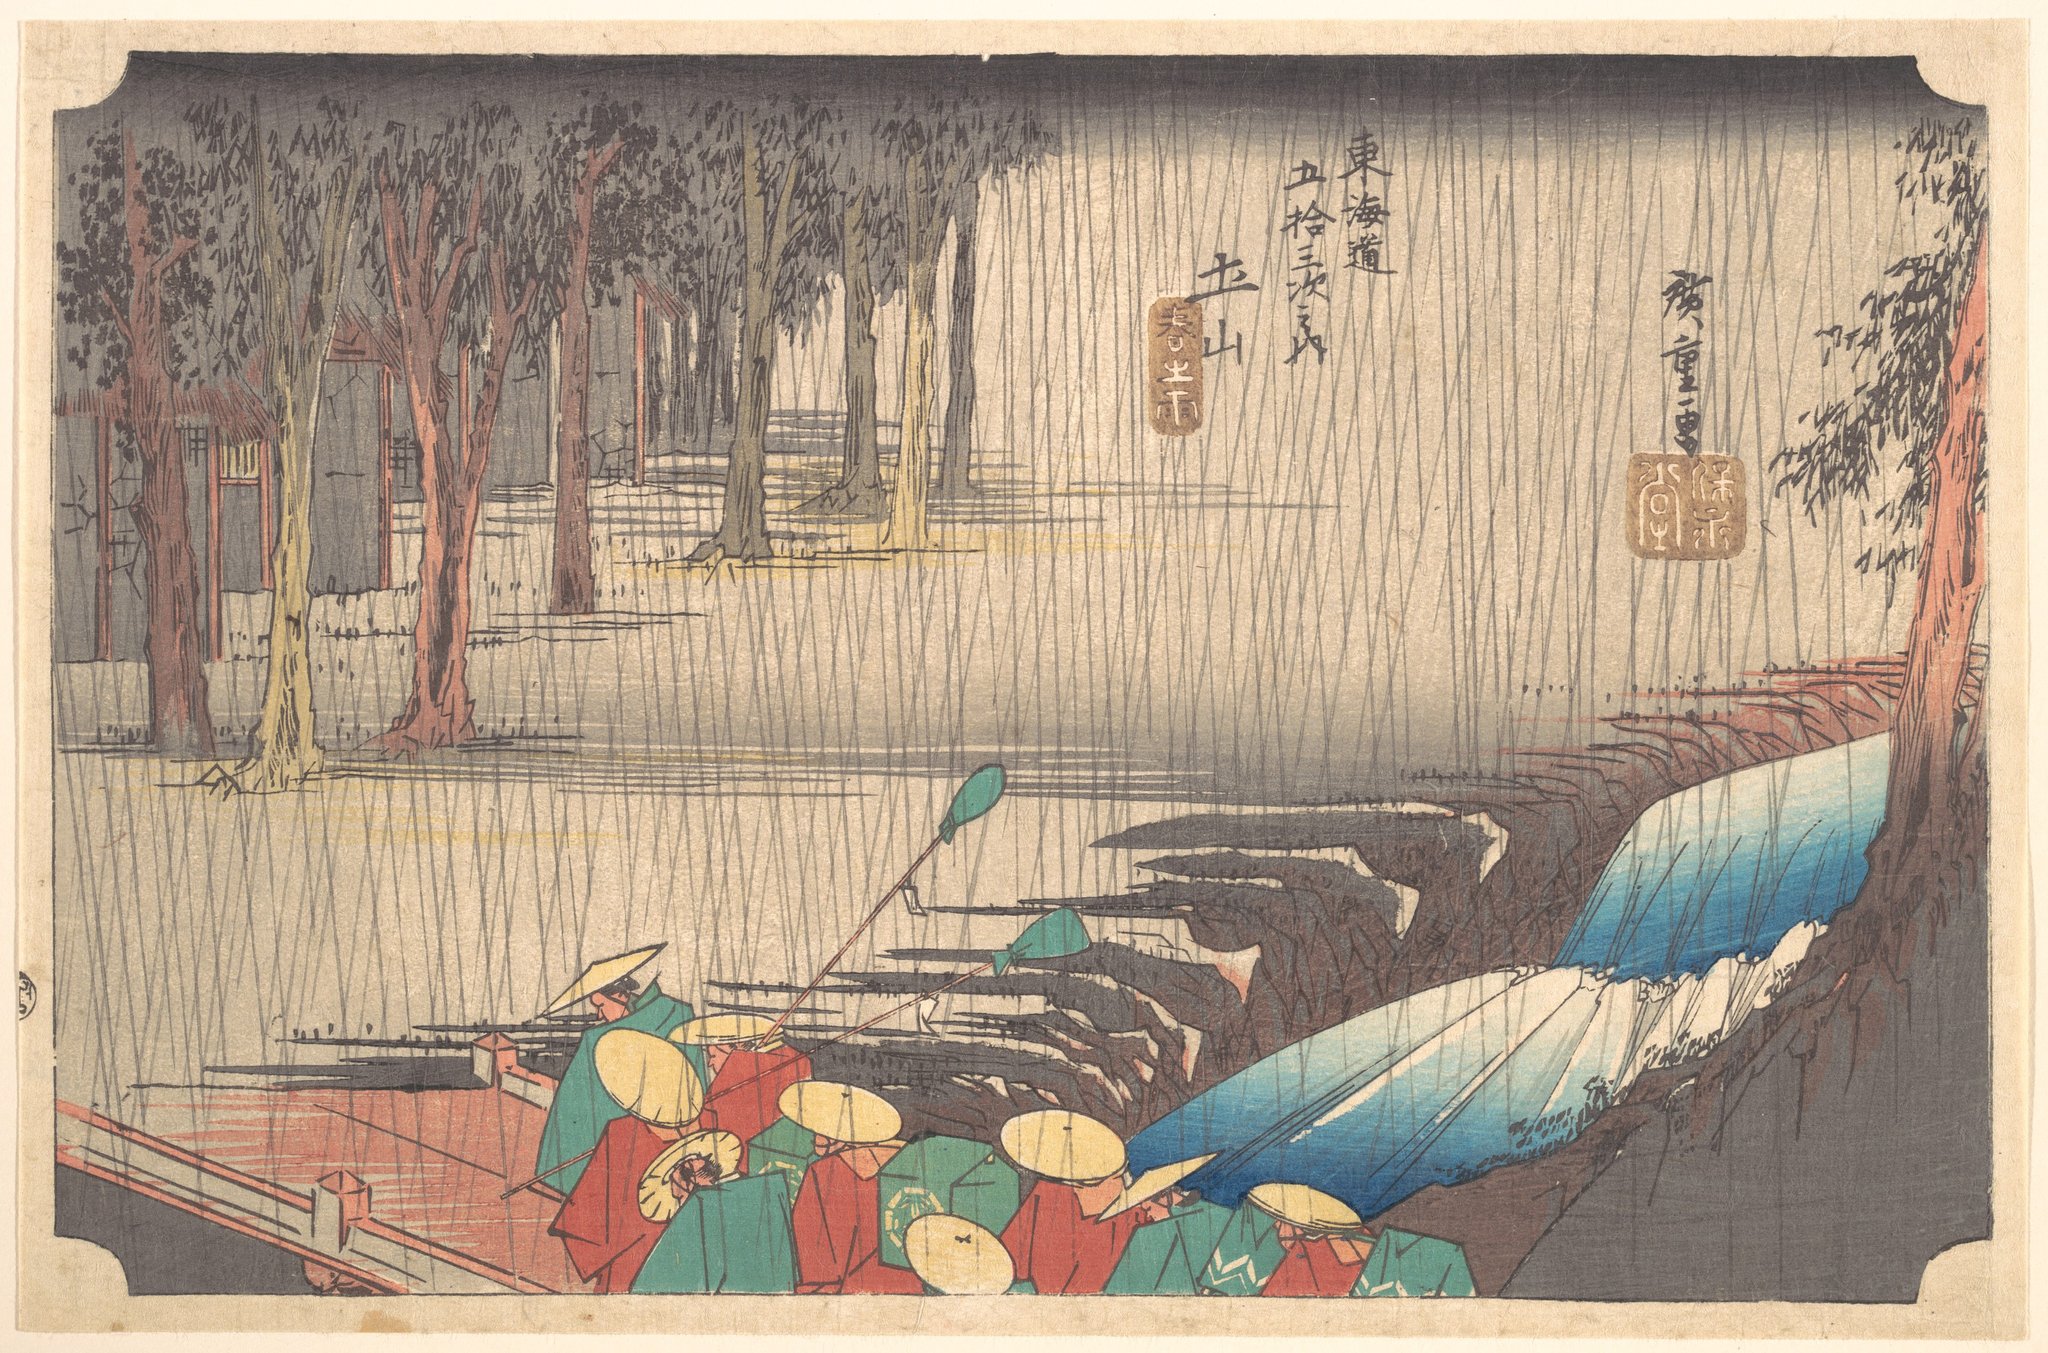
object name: print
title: Spring Rain at Tsuchiyama (50th Station of the Tōkaidō)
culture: japanese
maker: utagawa hiroshige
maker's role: artist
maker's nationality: japanese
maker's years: 1797-1858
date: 1797-1858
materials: ink, paper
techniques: woodblock print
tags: human figures,trees,rain